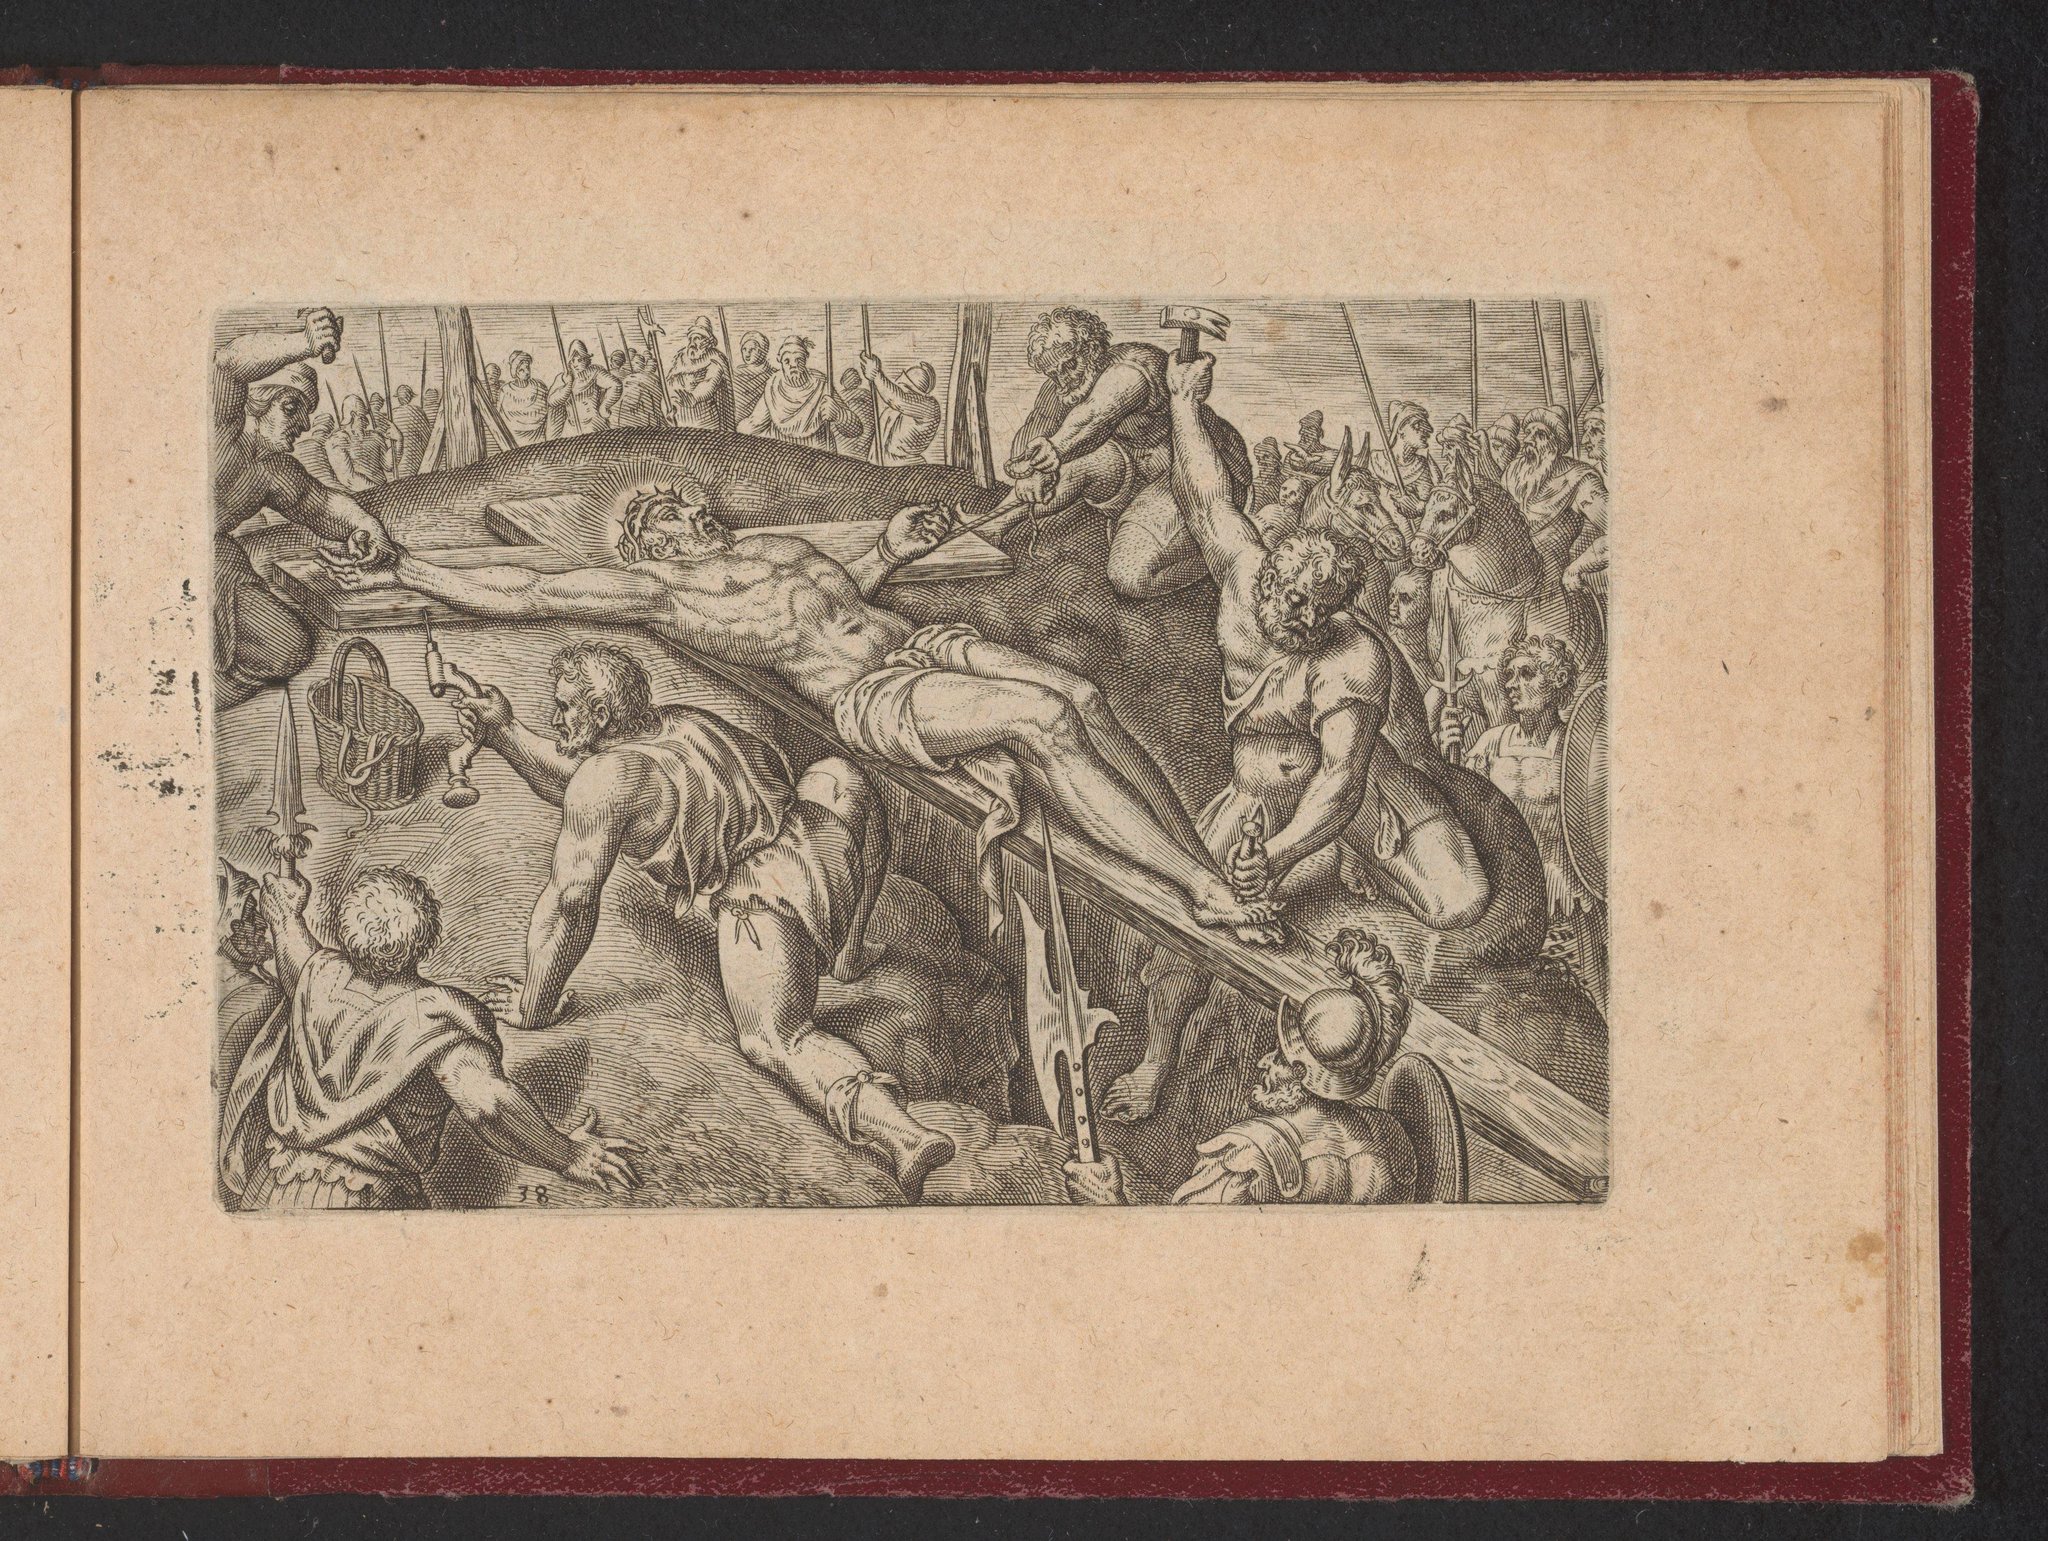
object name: print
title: Christi Iesu vitae admirabiliumque actionum speculum a Philippo Gallaeo apparatum Bened. Ariae Montani singuloribus distichis instructum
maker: philips galle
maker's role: print maker, publisher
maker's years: 1537-1612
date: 1573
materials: paper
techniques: engraving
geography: antwerp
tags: the erection of the cross: christ is nailed to the cross which lies on the ground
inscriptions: watermark: ‘gotische letter P’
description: Onderdeel van een album met een titelprent en een serie van 50 prenten betreffende het leven en de passie van Christus.